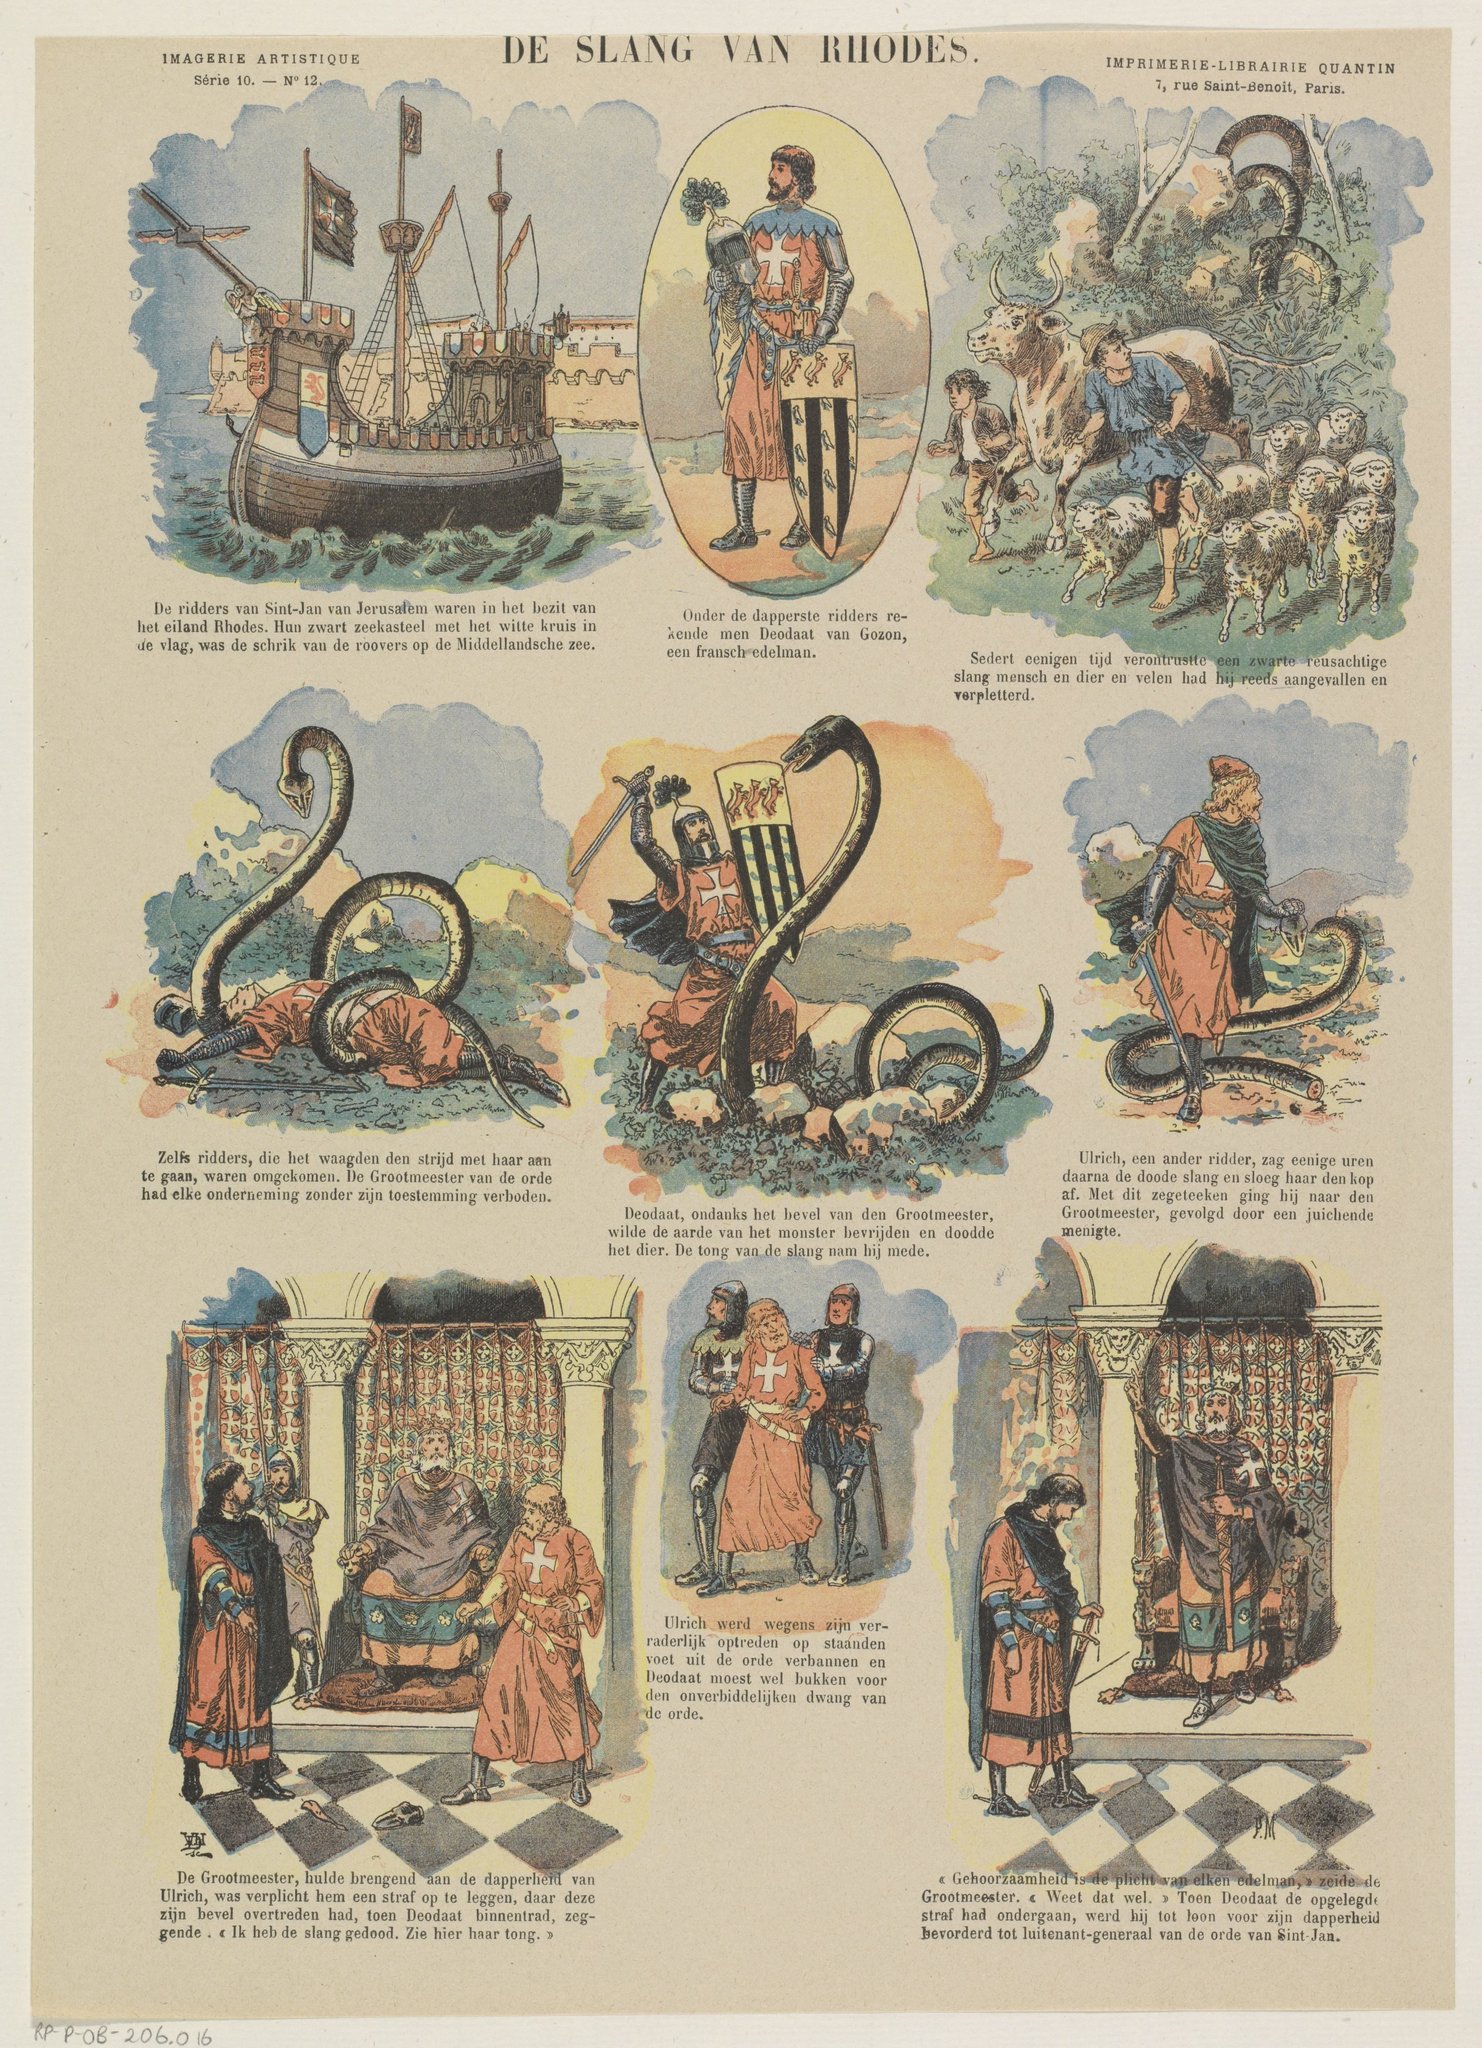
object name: print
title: Imagerie Artistique / Série 10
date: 1876-1890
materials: paper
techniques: lithograph, letterpress printing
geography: paris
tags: snakes, tales and fairy tales, nobility and patriciate; chivalry, knighthood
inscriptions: collector's mark: Lugt 2760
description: Blad met 9 voorstellingen van een dappere ridder die een reusachtige slang verslaat. Een andere ridder probeer de eer op te strijken, maar wordt gestraft. Onder elke afbeelding een onderschrift. Genummerd linksboven: Série 10. - No. 12.